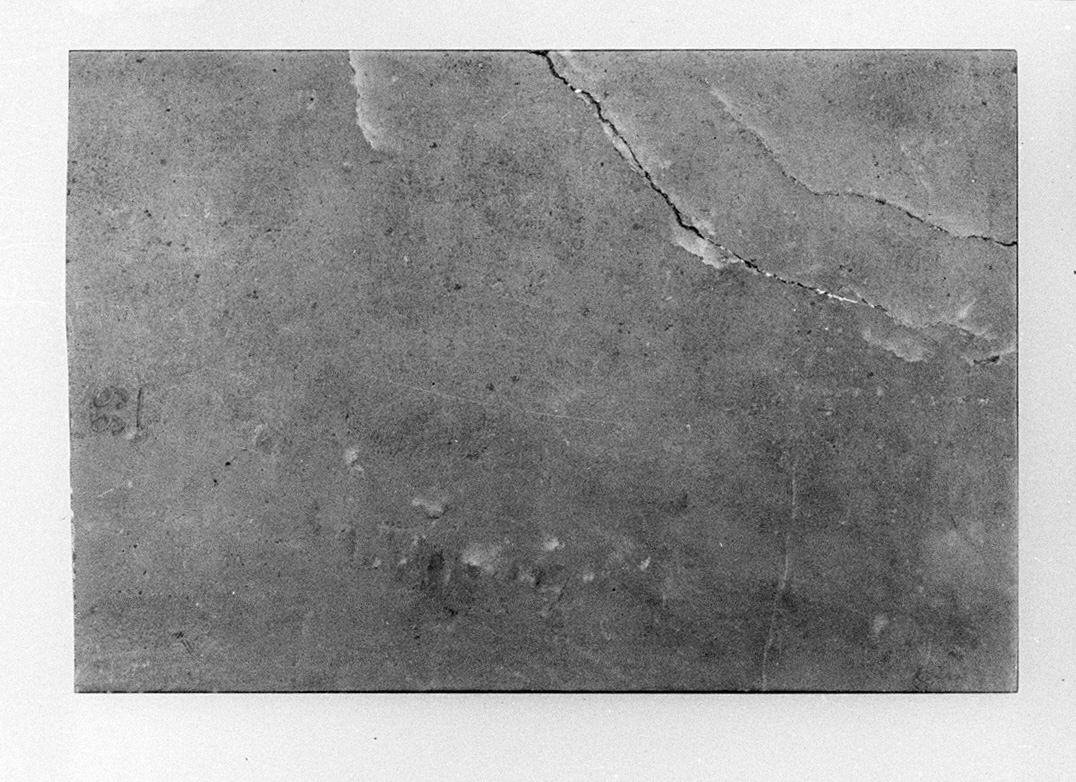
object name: fragment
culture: chinese or turkestani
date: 1902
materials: jade